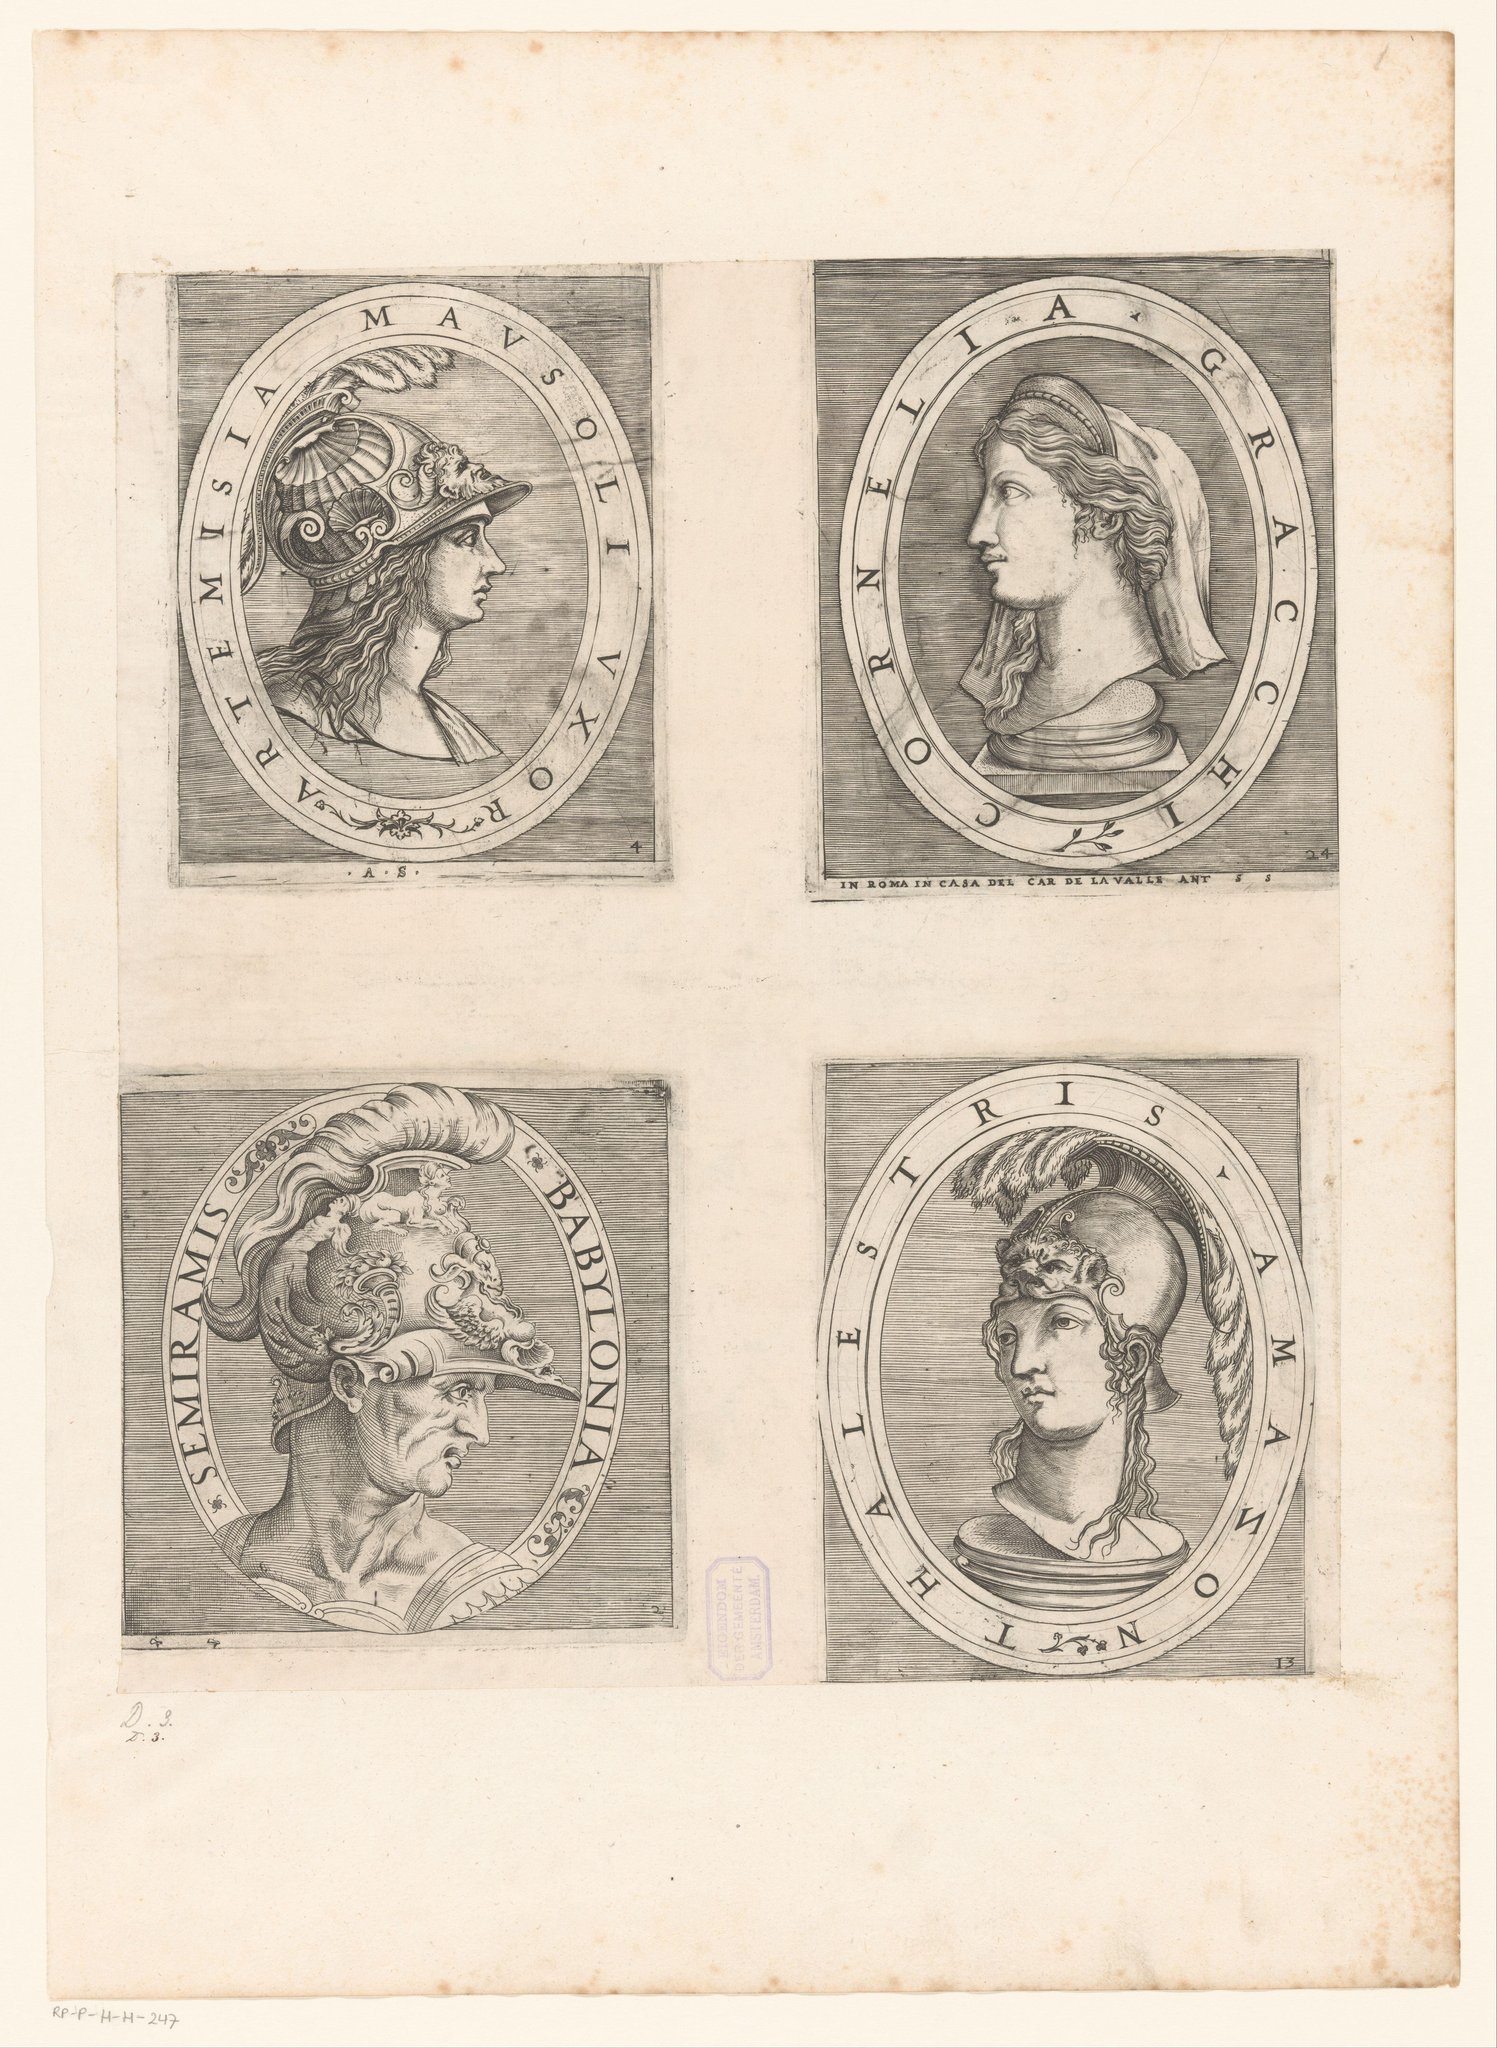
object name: print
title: Artemisia Mausoli Uxor/ Cornelia Gracchi/ Semiramis Babylonia/ Thalestris Amazon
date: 1510-1562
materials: paper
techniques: engraving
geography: rome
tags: helmet, historical persons - bb - woman, historical persons, piece of sculpture, reproduction of a piece of sculpture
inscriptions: collector's mark: Lugt 11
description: Blad met vier voorstellingen van medaillons met bustes. Linksboven: portretbuste van Artemisia Mausoli Uxor. Genummerd rechtsonder: 4. Rechtsboven: portretbuste van Cornelia Gracchi. Genummerd rechtsonder: 24. Linksonder: Semiramis Babylonia. Genummerd rechtsonder: 2. Rechtsonder: portretbuste van Thalestris Amazon. Genummerd rechtsonder: 13.